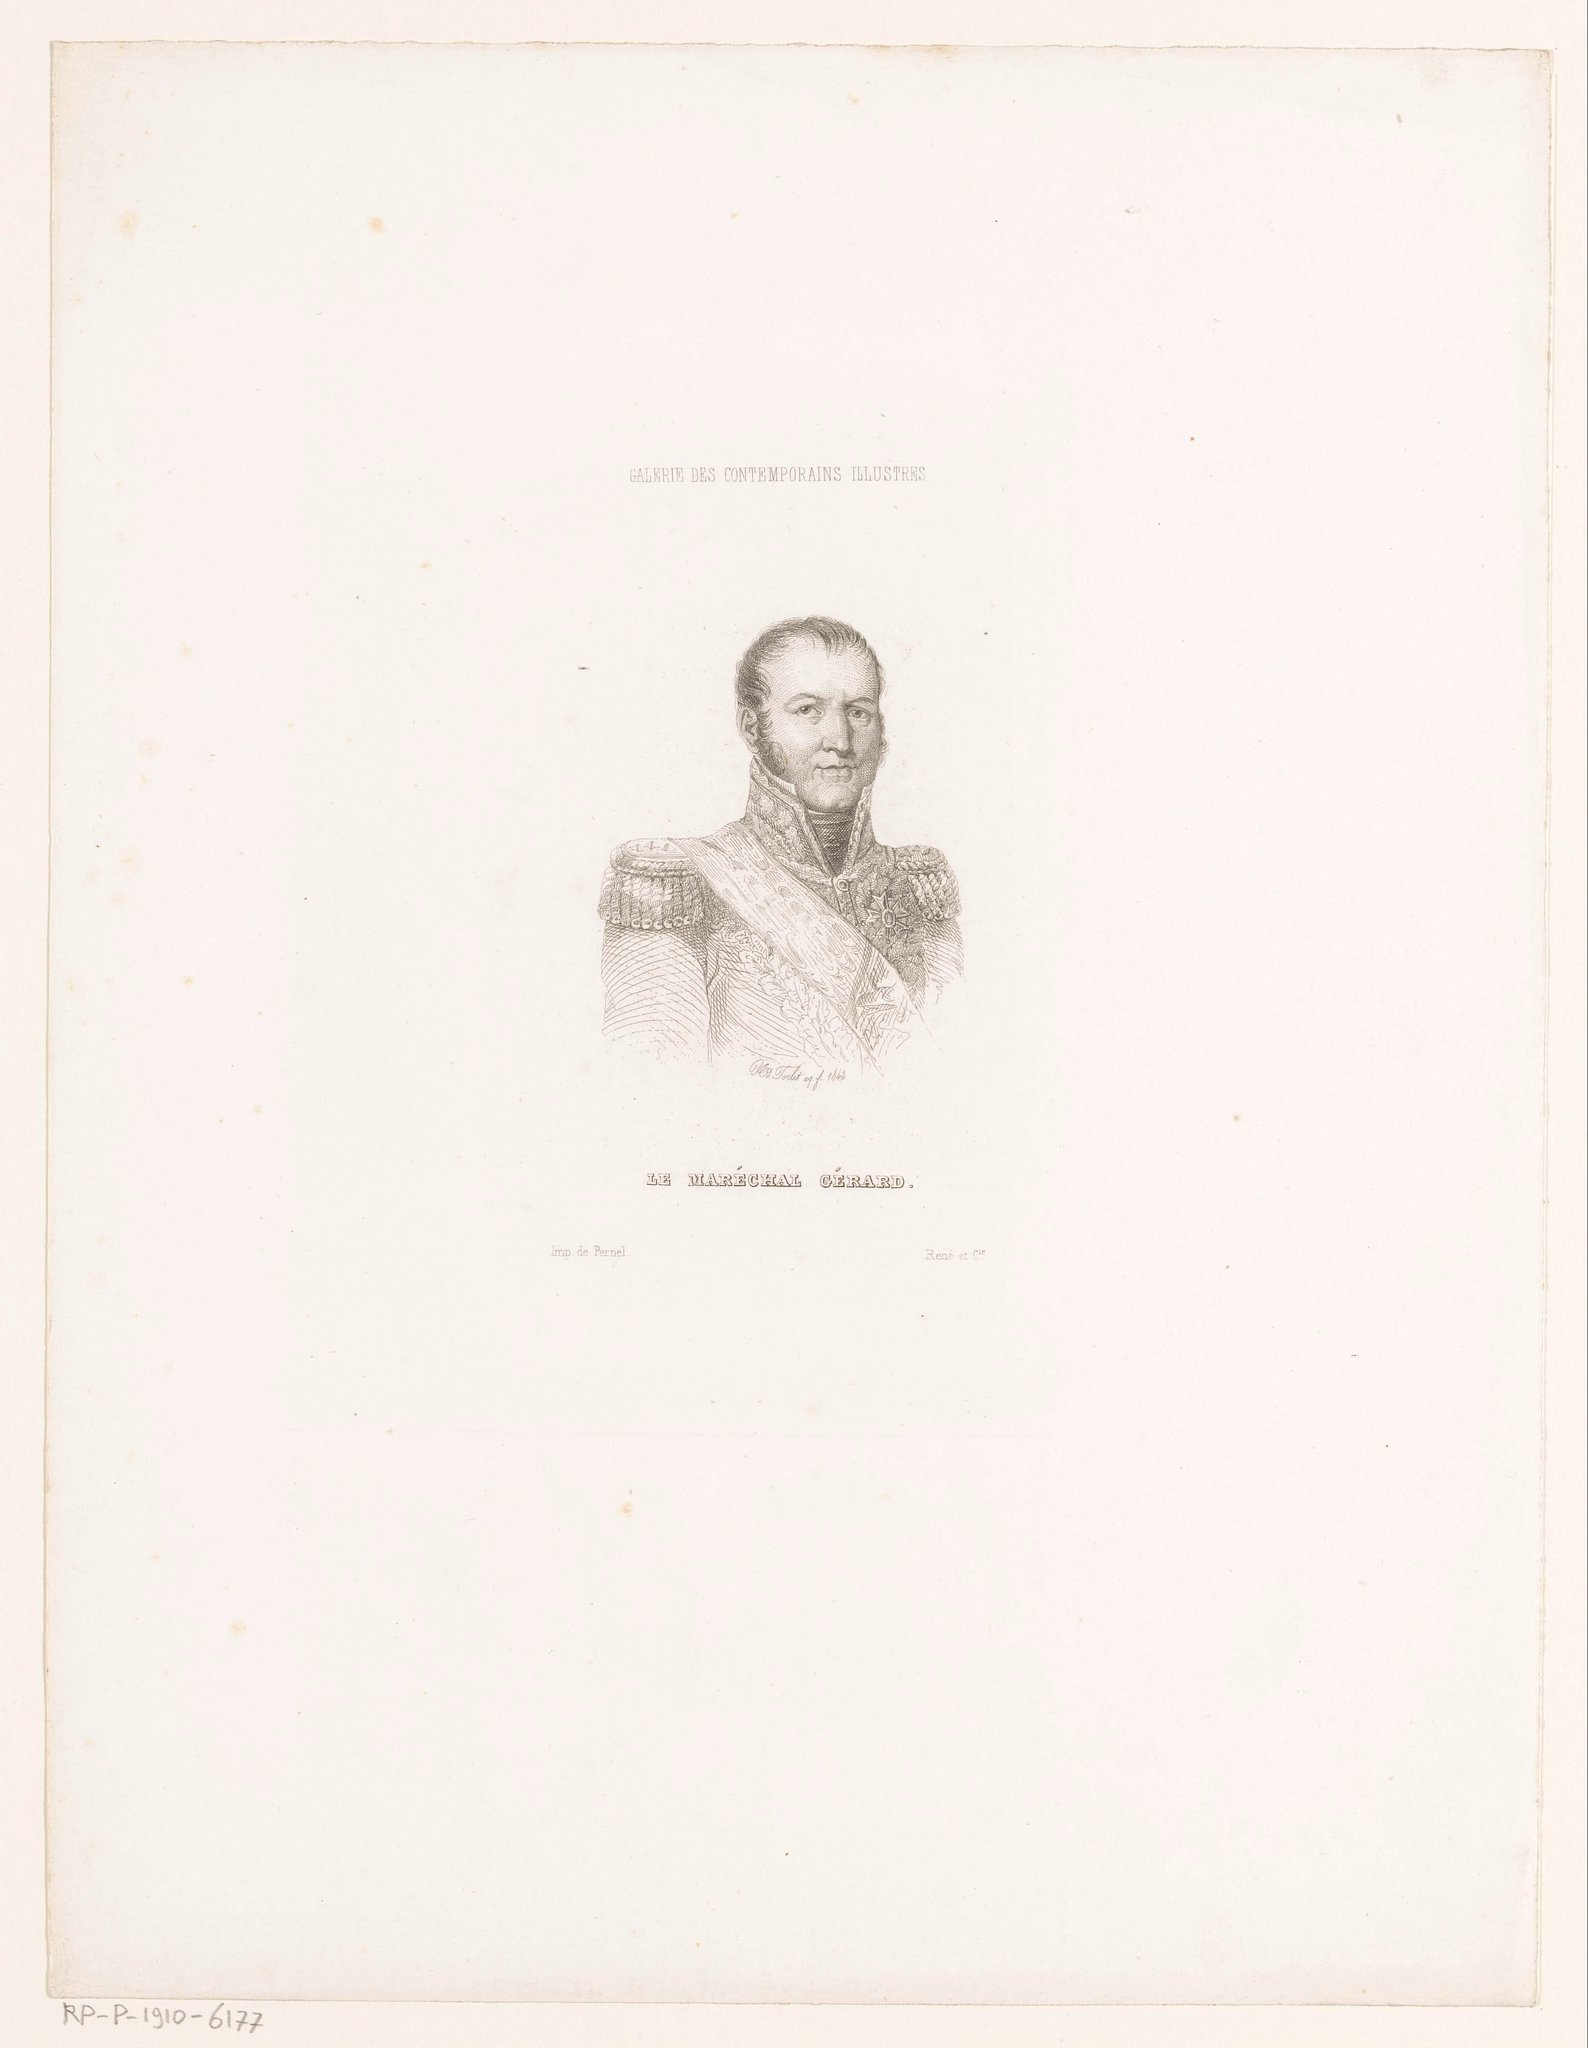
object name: print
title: Portretten van bekende tijdgenoten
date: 1843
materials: paper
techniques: etching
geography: france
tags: commander-in-chief, general, marshal, historical persons, decorations, honours (as symbols of the state, etc.)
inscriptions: collector's mark: Lugt 2228